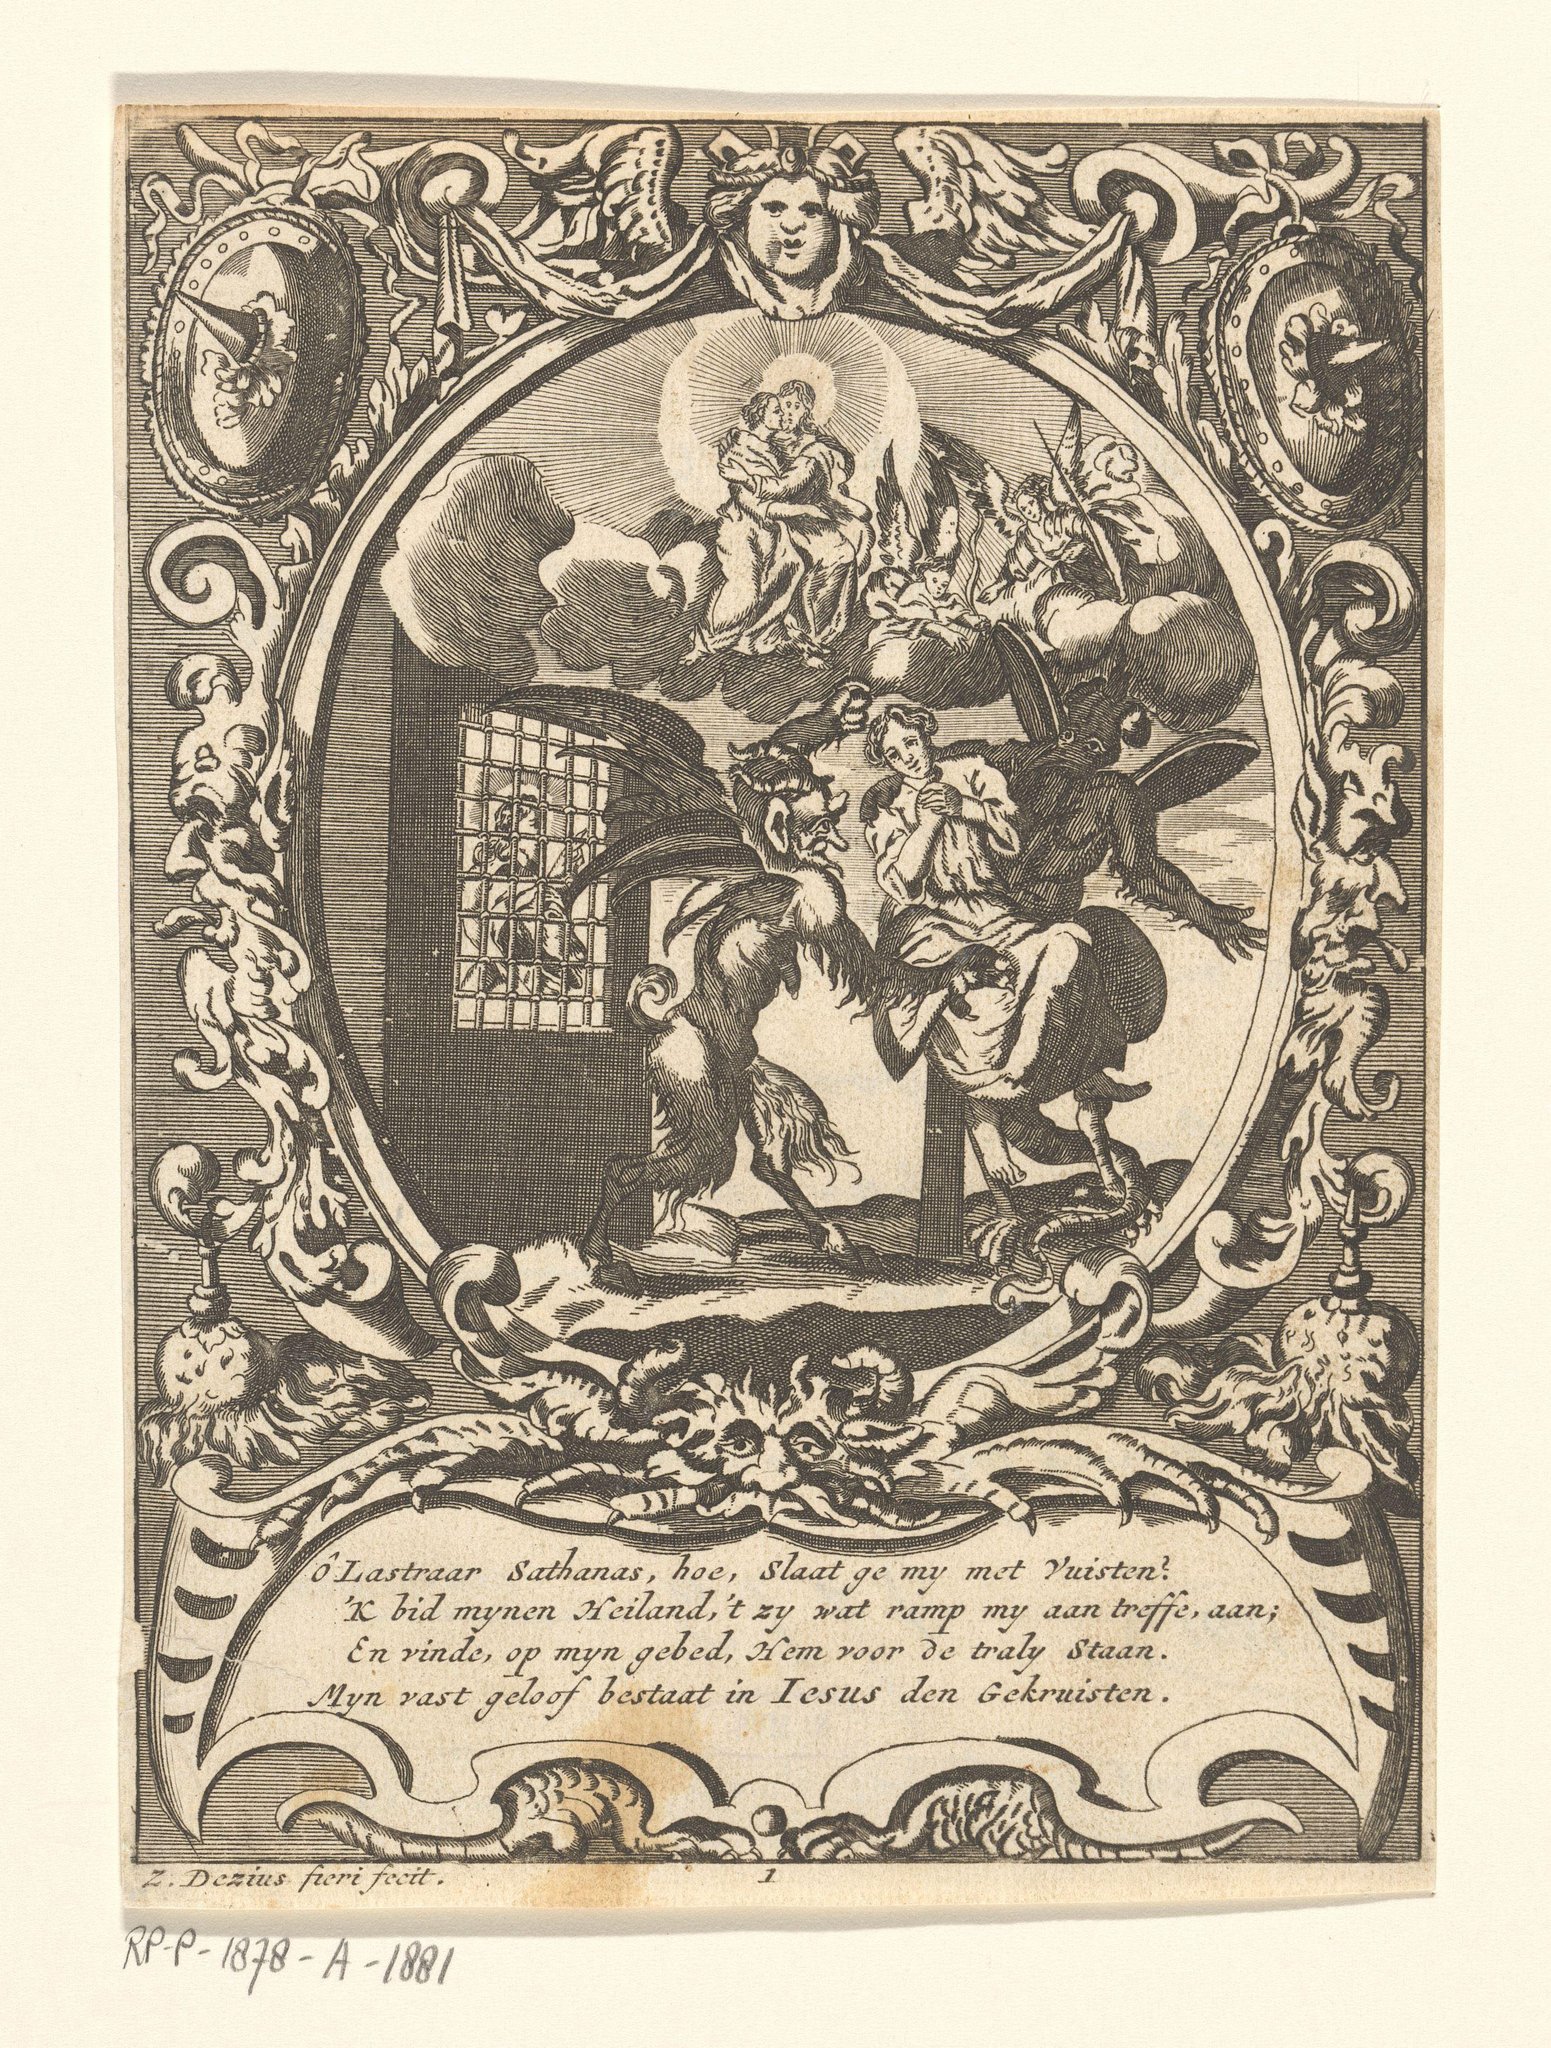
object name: print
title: Mens door duivels belaagd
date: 1713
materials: paper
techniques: etching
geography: rotterdam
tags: devil or demons attacking mortals, christ triumphing over devil(s)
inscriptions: collector's mark: Lugt 2228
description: Een mens wordt door twee duivels belaagd. Achter een tralieraam staat Christus. Op de wolken de mens in de armen van Christus en gered van de duivel. Rond de voorstelling ornamenten. Onderaan op een cartouche een vierregelig vers over de voorstelling in het Nederlands.